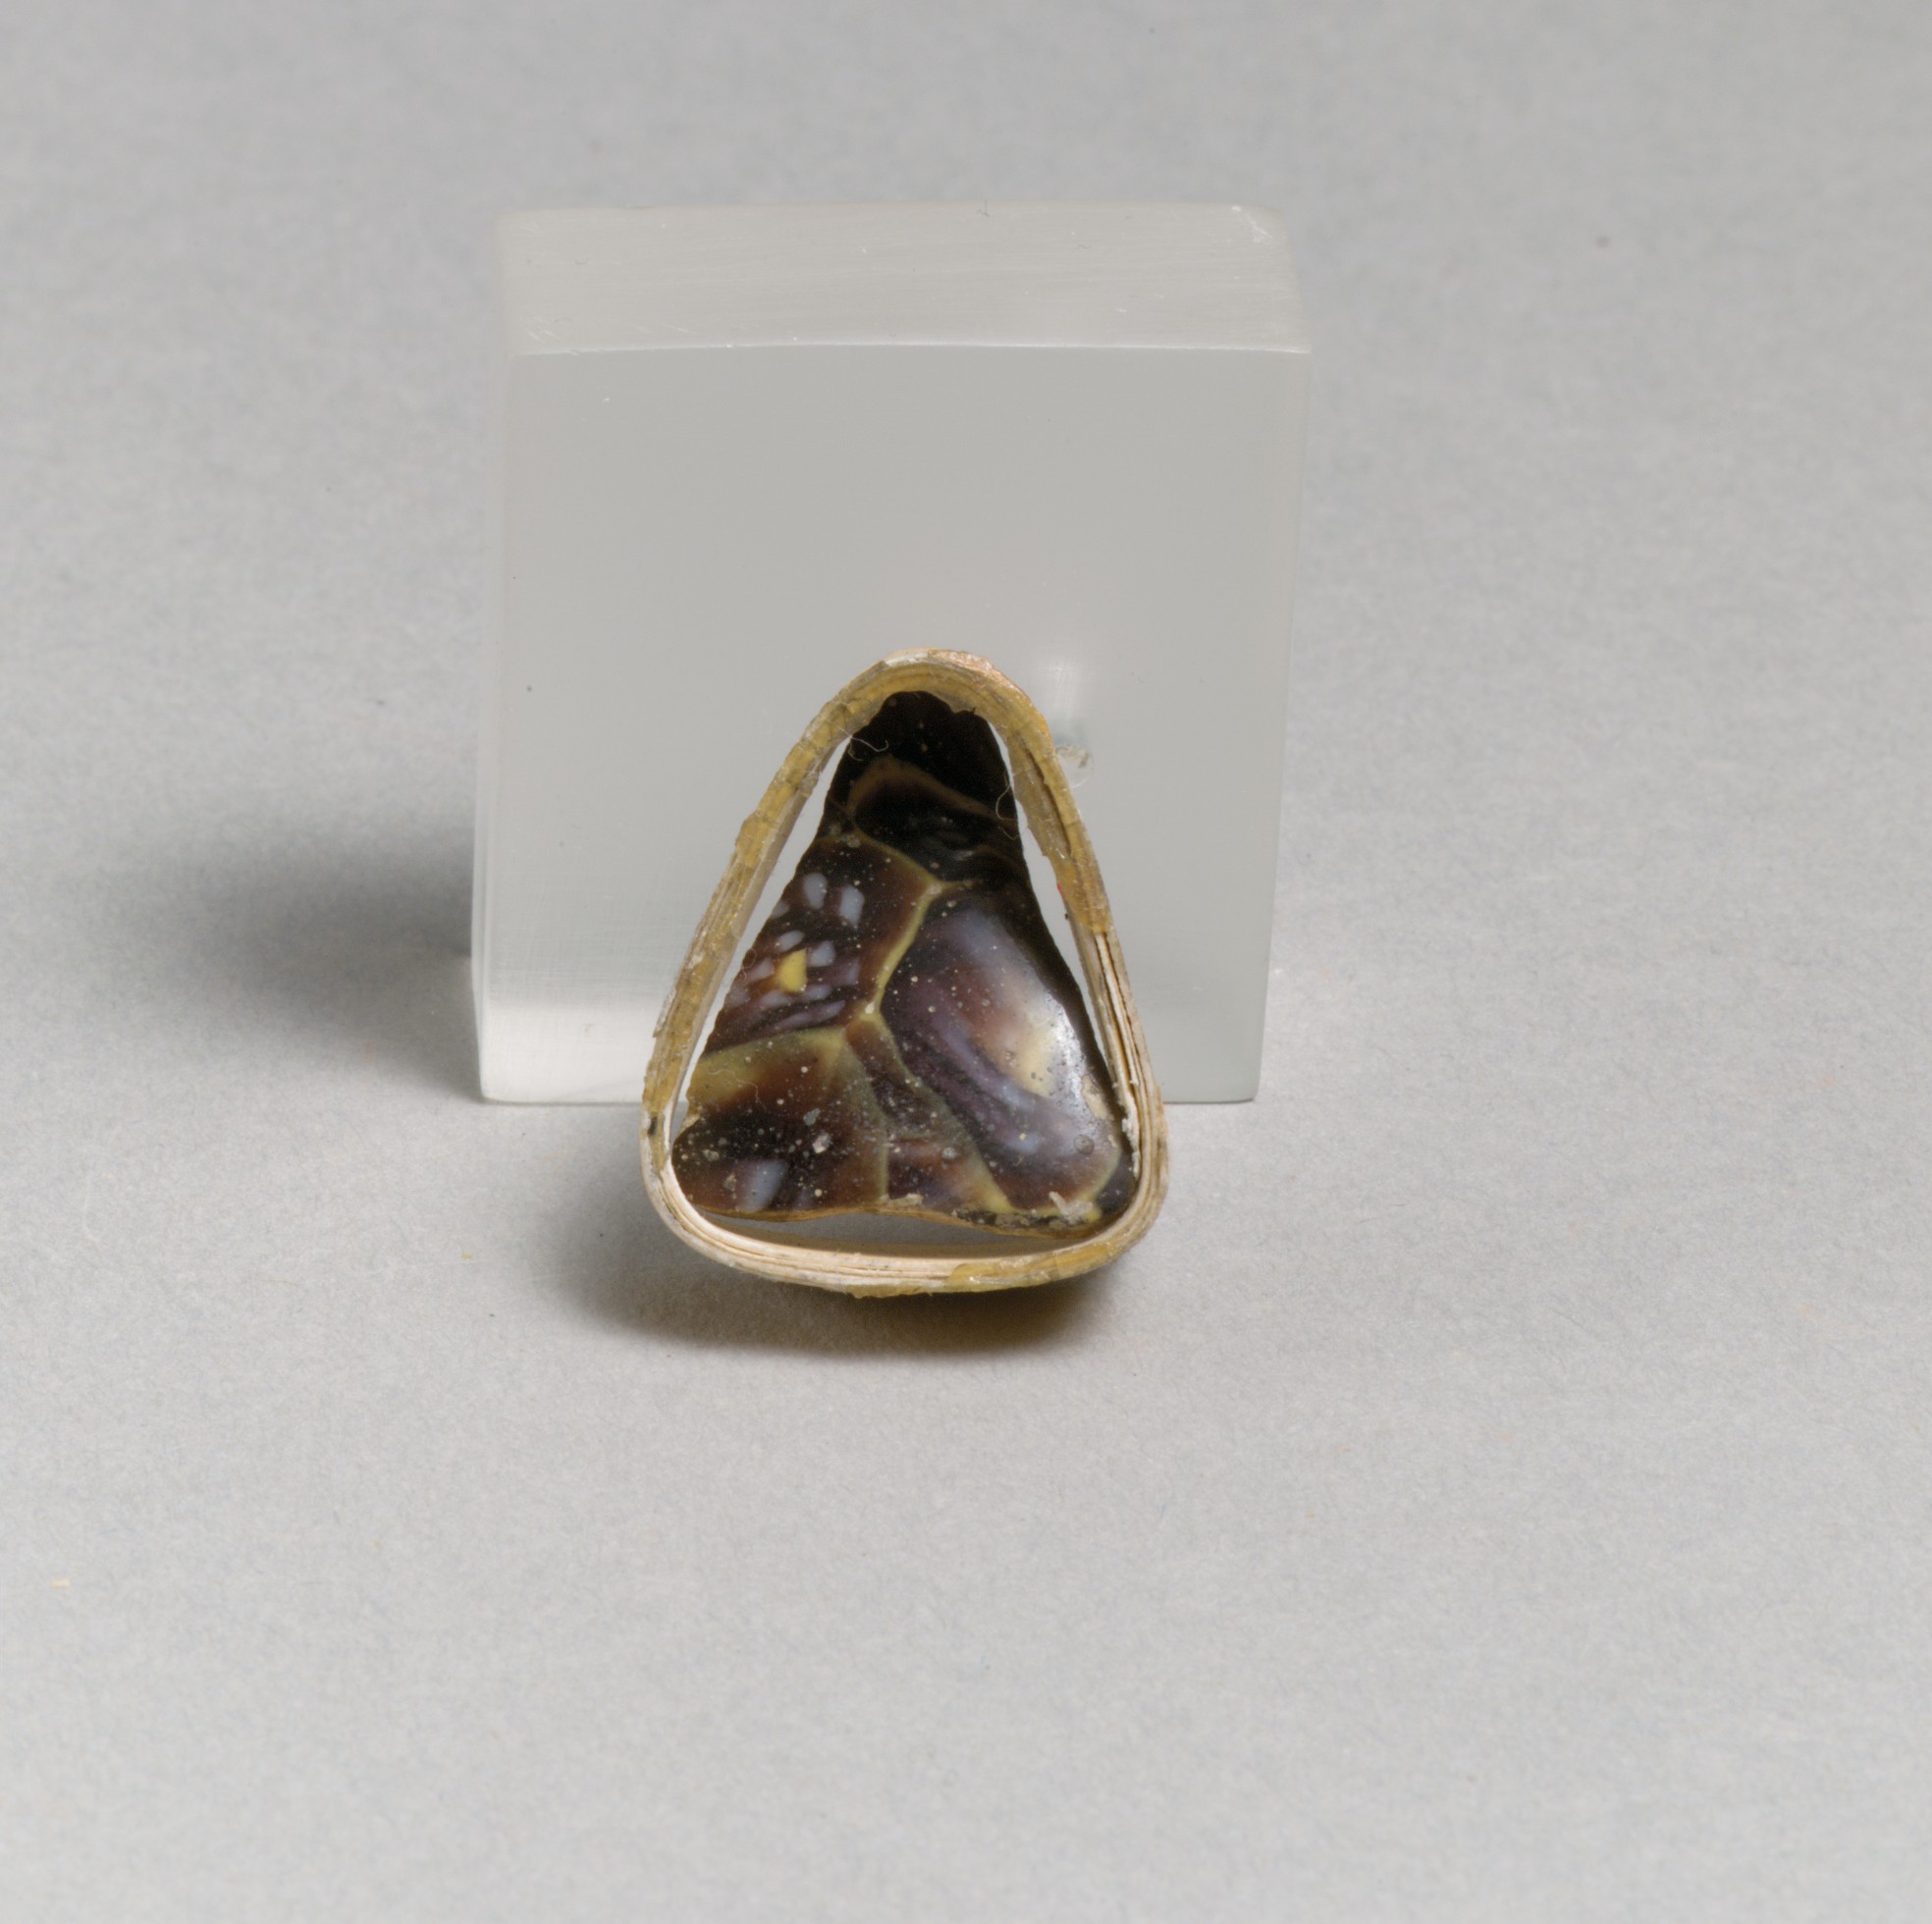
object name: fragment, mosaic bowl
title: Glass mosaic carinated bowl fragment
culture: roman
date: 34 BCE-33 CE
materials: glass